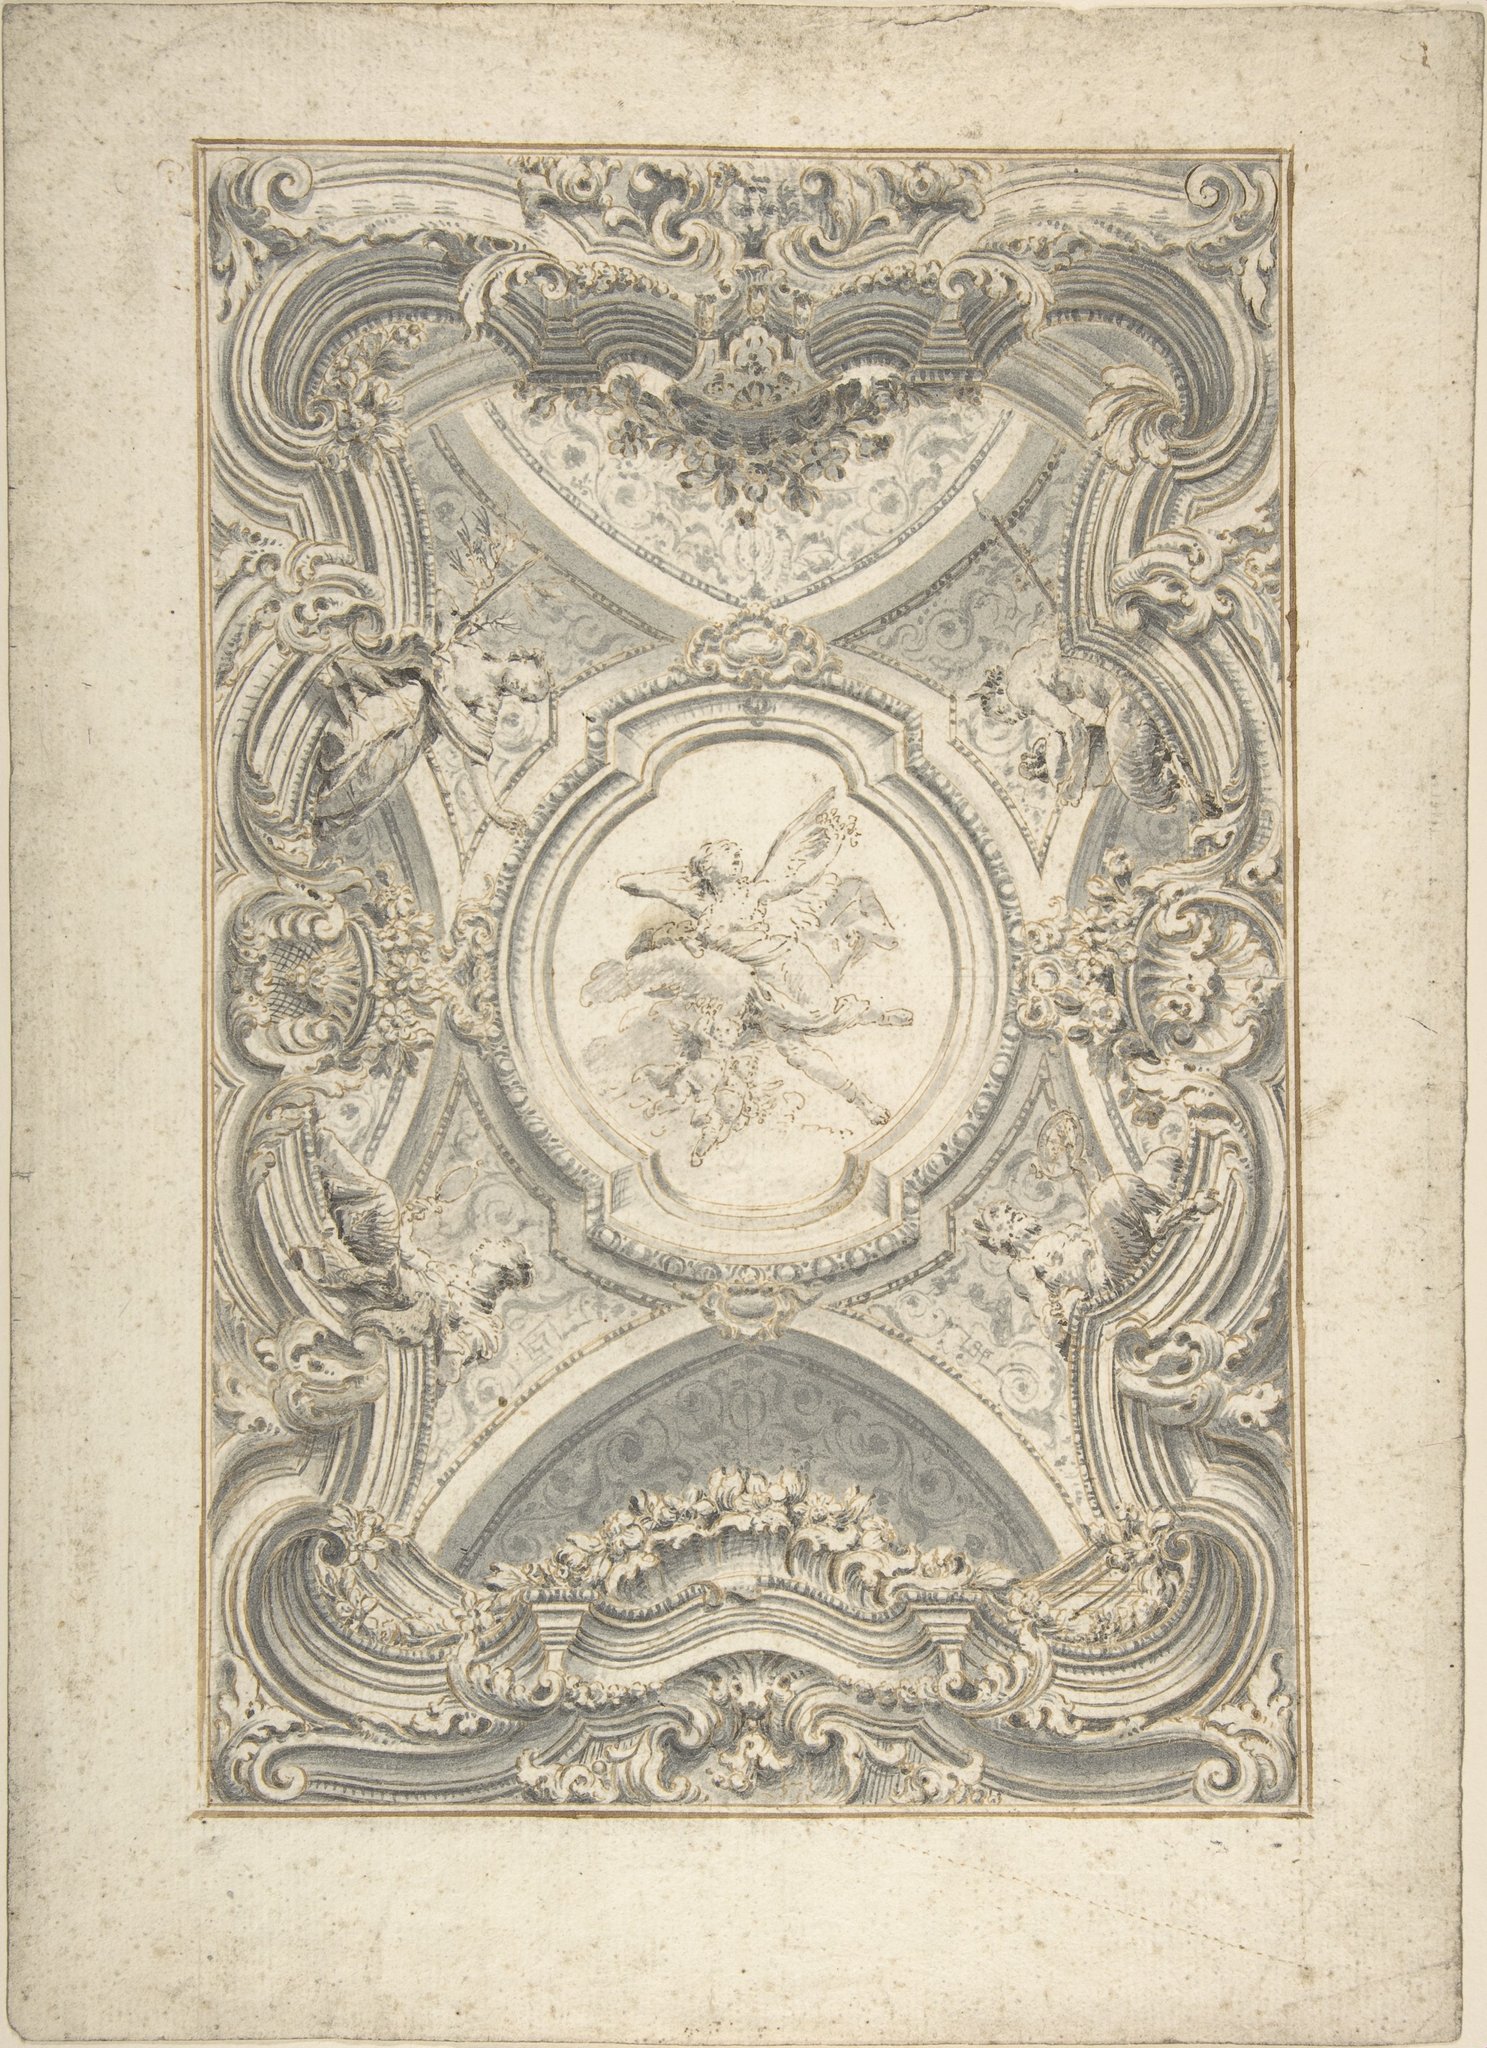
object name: drawing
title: A Baroque Ceiling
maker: anonymous, italian, 18th century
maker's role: artist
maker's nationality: italian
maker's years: 1700-1800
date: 1701-1800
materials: ink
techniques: pen, wash